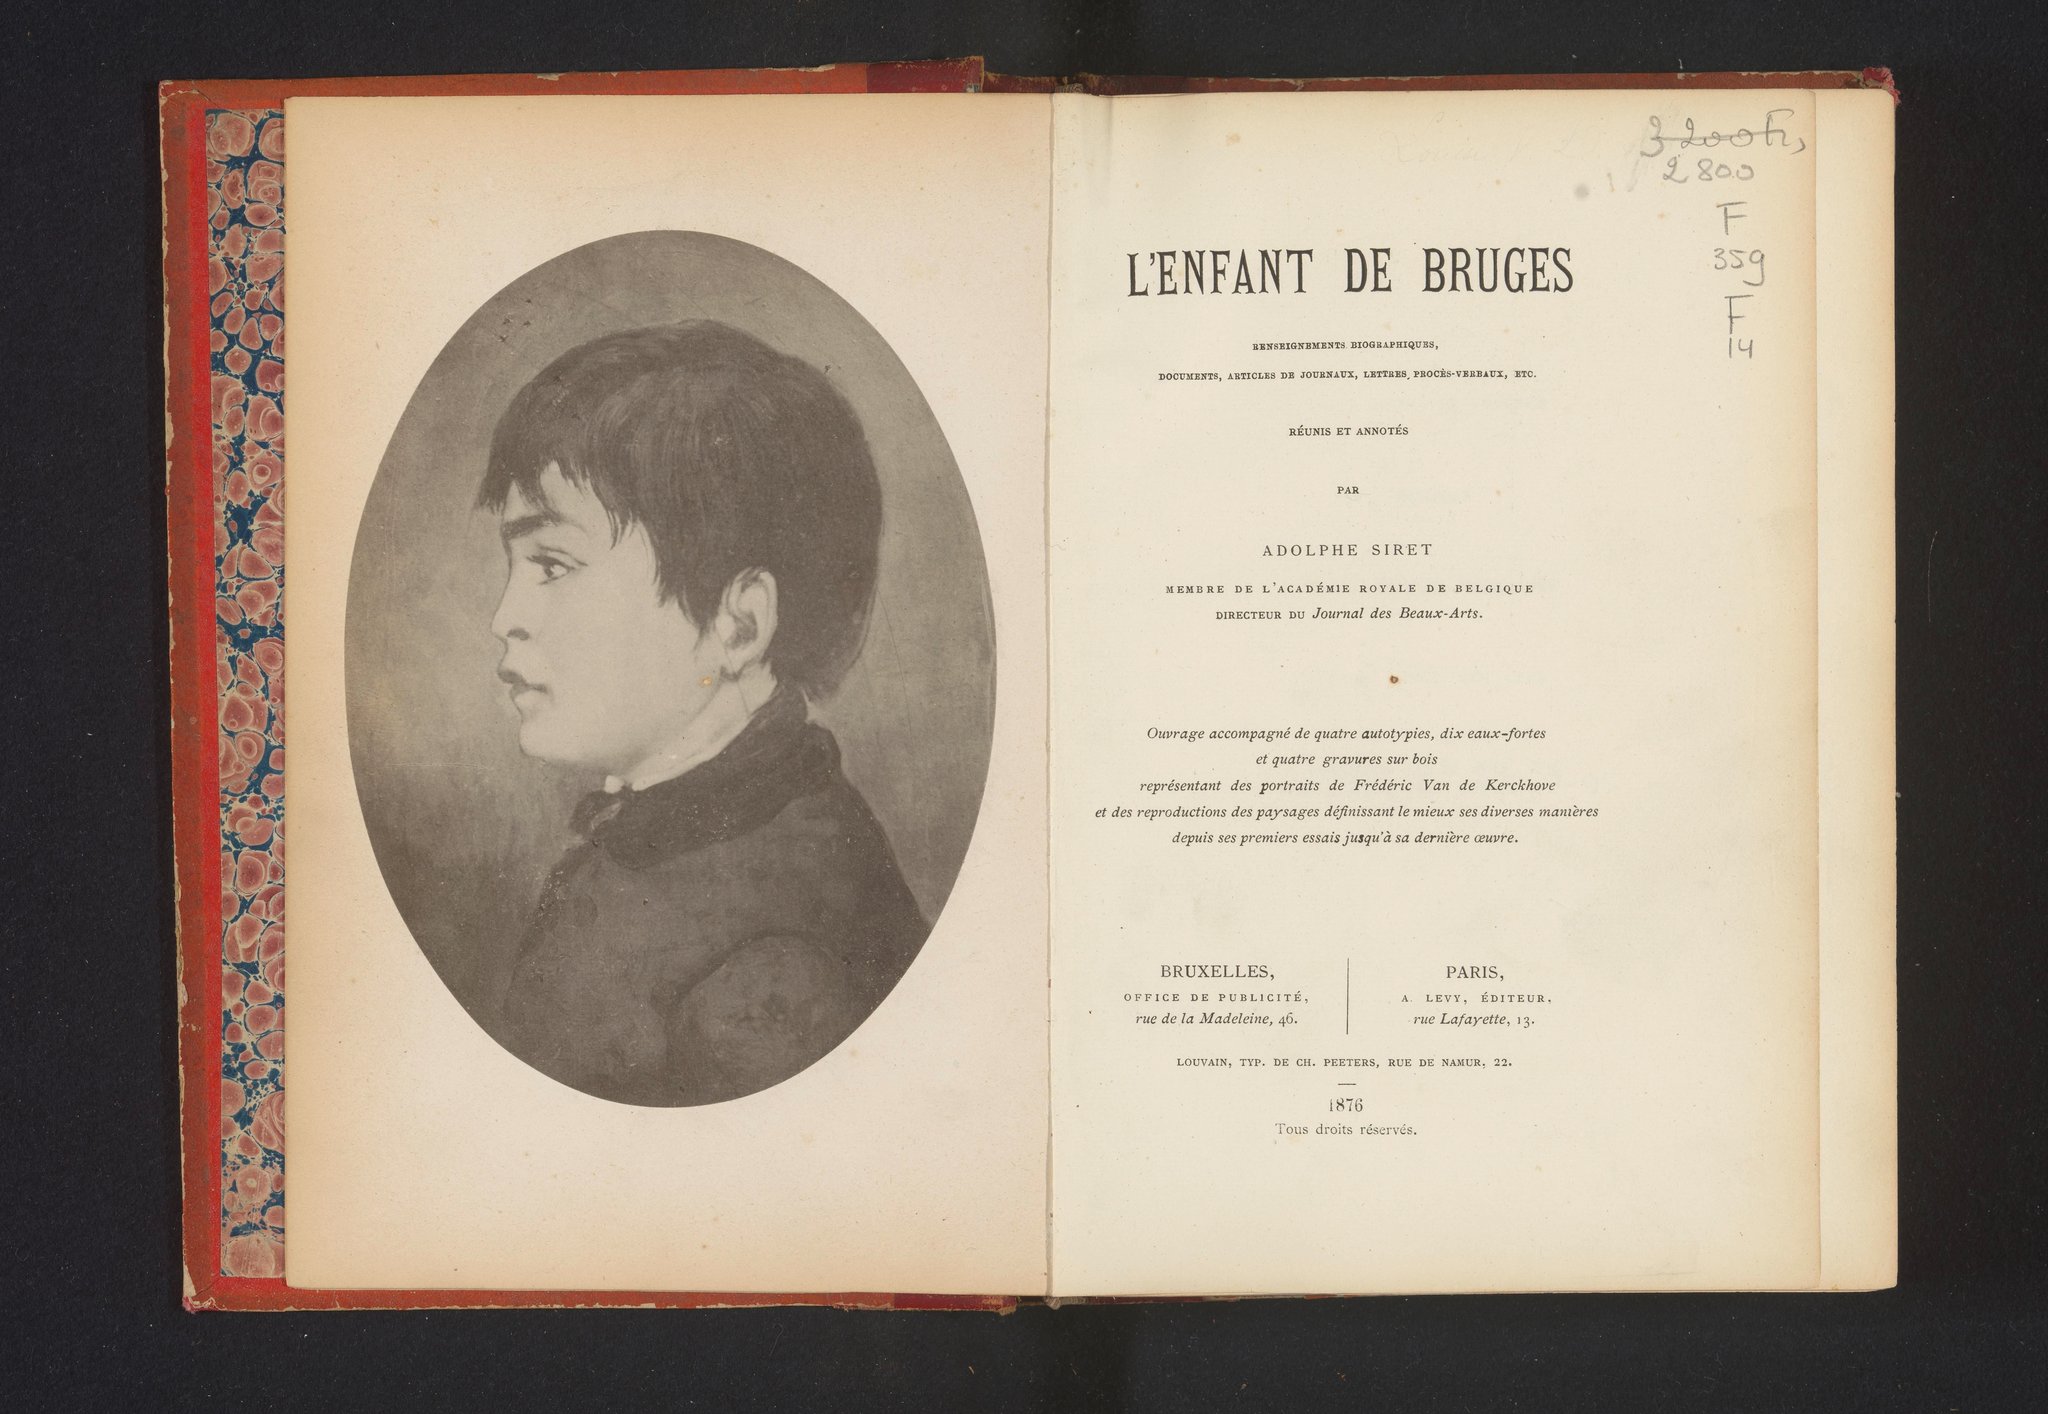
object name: reproduction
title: Reproductie van een schilderij van een portret van Frédéric van de Kerkhove door Jean van de Kerkhove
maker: Anonymous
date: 1871-1876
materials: paper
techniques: photograph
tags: bruges, painter, frédéric van de kerkhove, historical persons